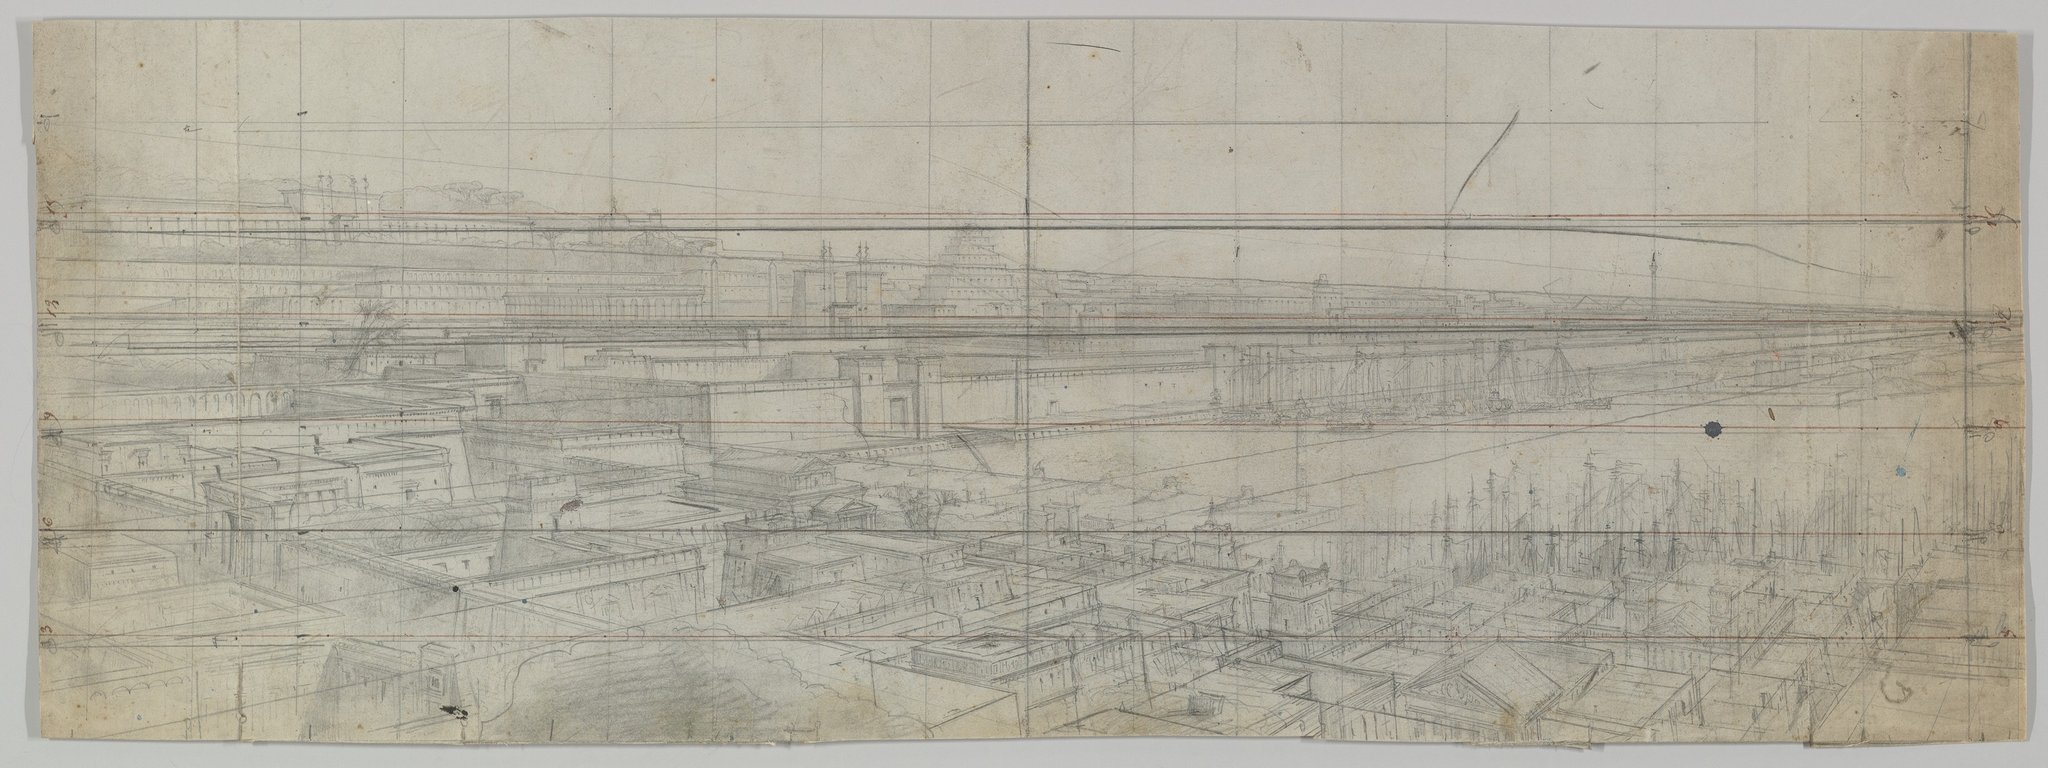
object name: drawing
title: Design for a Stage Set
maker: eugène cicéri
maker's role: artist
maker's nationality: french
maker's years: 1813-1890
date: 1830-1890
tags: stage design